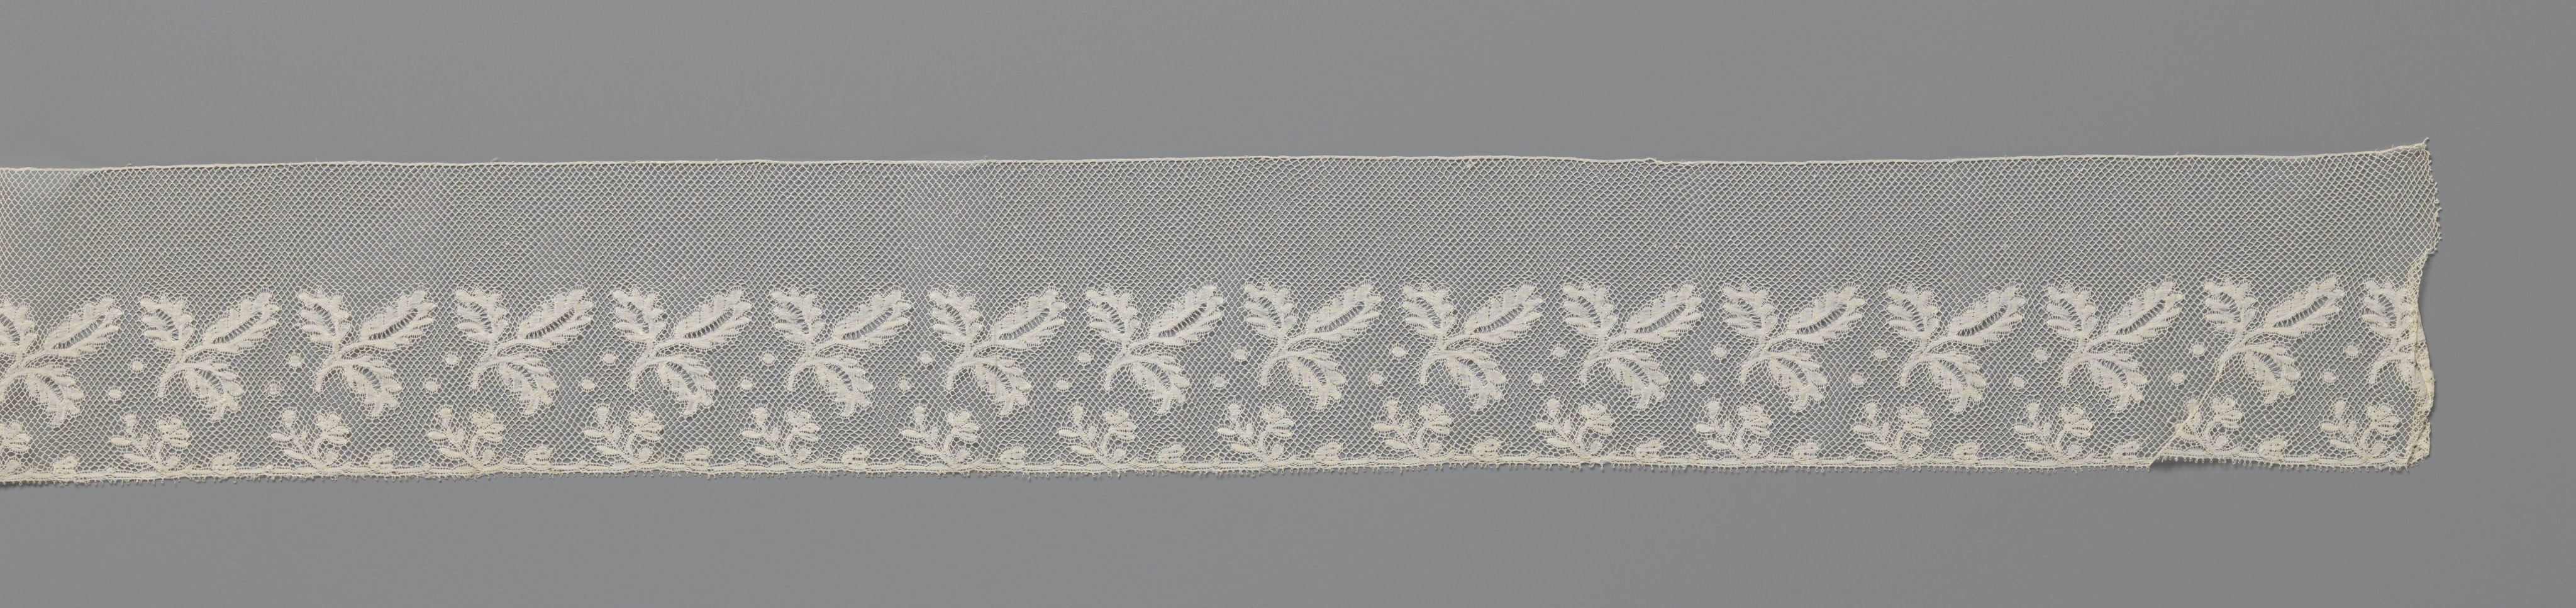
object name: strip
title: Strook kloskant met drieblad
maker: Anonymous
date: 1820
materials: linen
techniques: lace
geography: ieper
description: Op een fijn mazennet staat in de buitenste helft een stijve rij van drie-delige blaadjes, die eenzijdig gericht zijn. Een rechte rand vertoont kleinere, tegengesteld gerichte bloemtakjes. Valenciennes-kant.